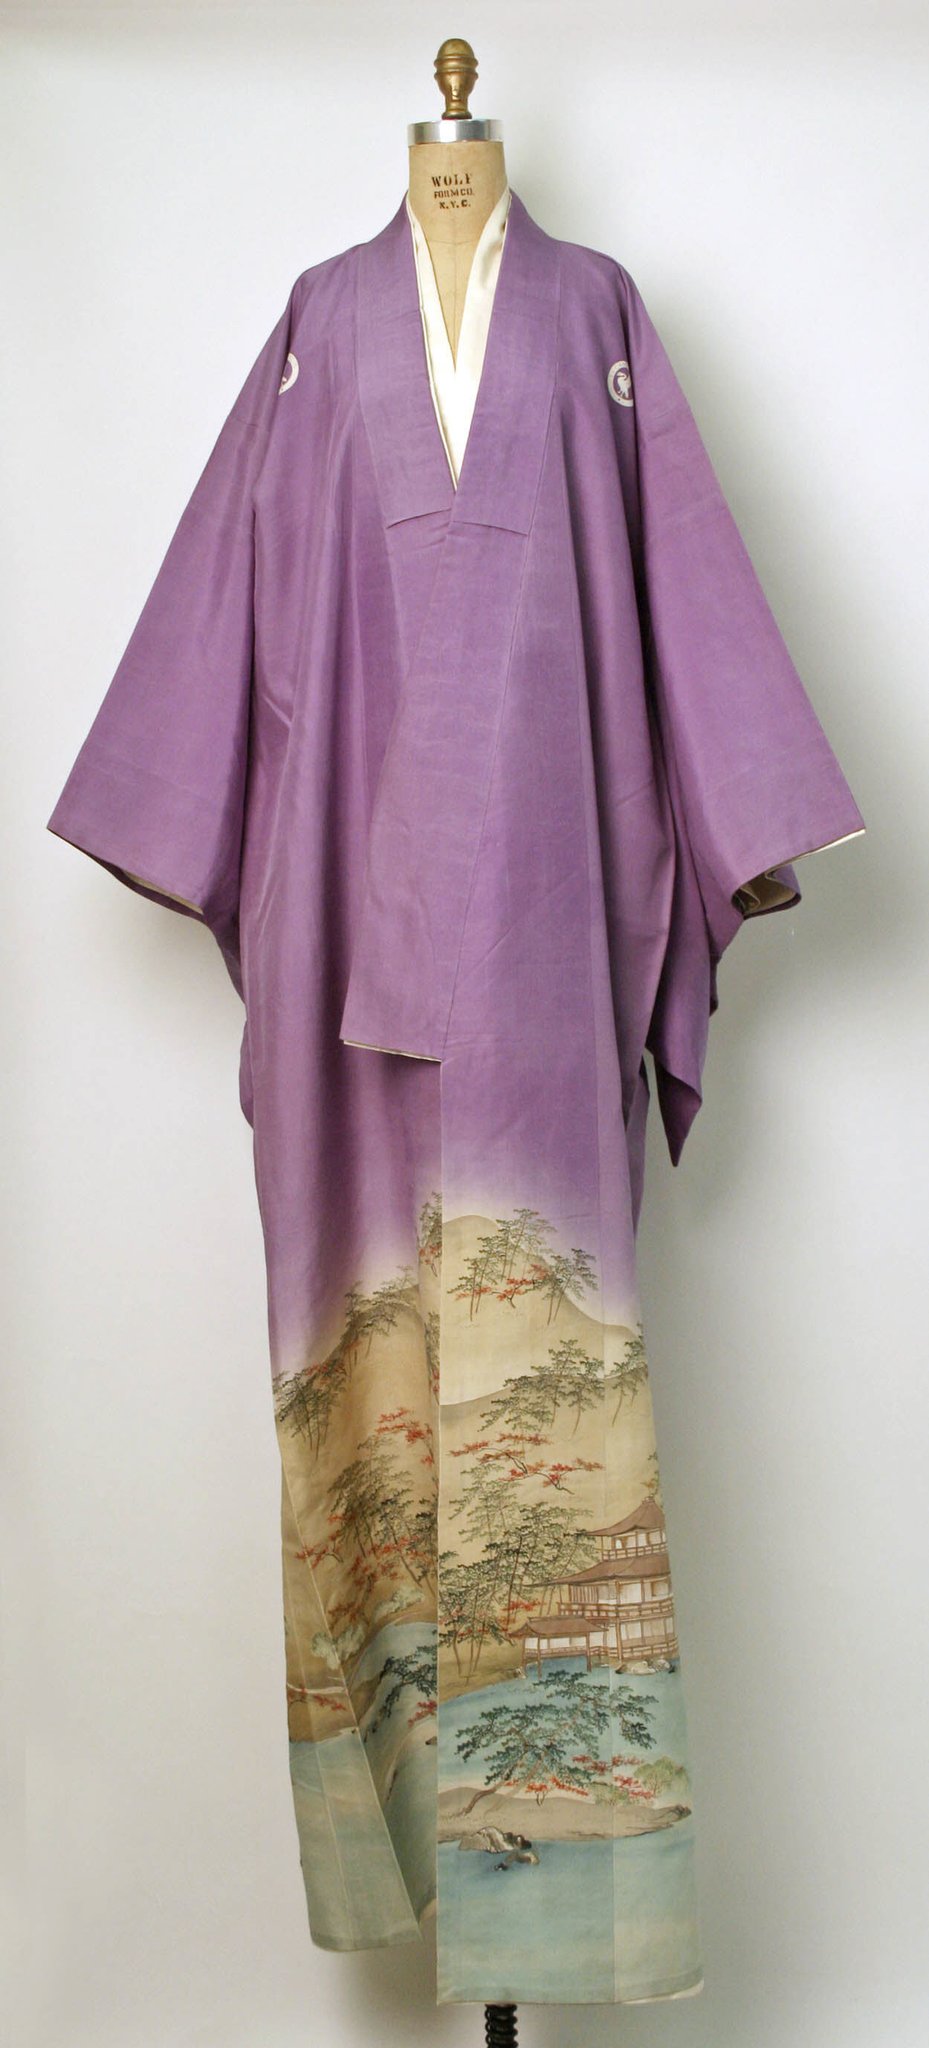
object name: ensemble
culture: japanese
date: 1906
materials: silk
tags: landscapes